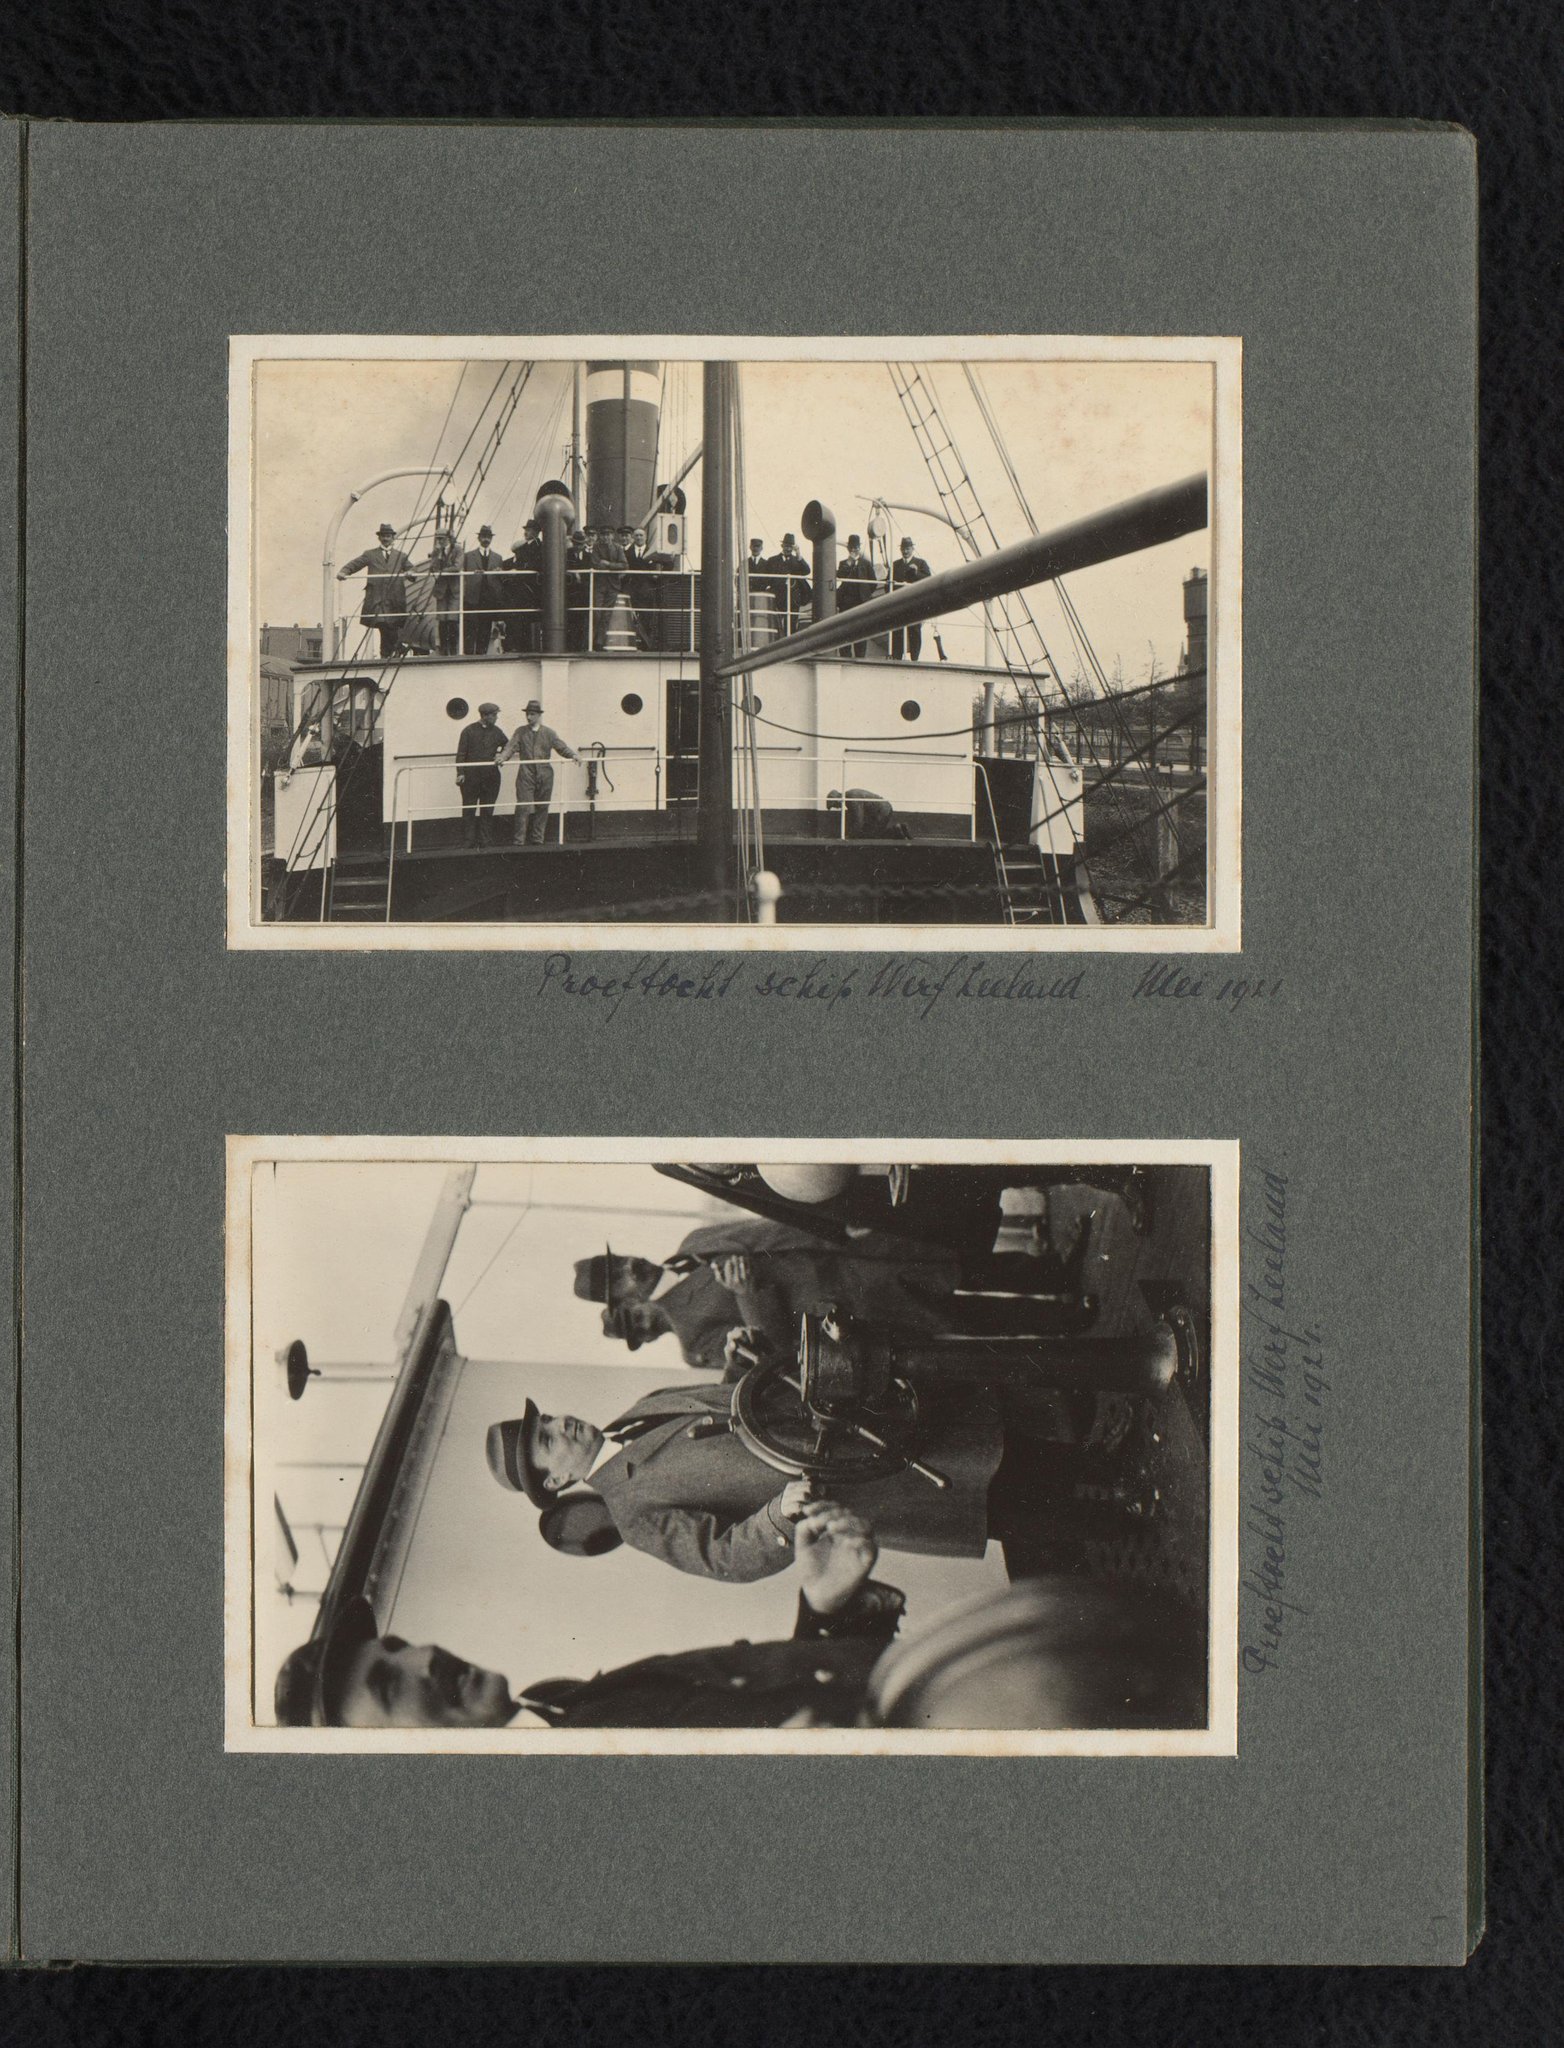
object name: photograph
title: Twee foto's van het schip Werf Zeeland tijdens een proefvaart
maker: hendrik herman van den berg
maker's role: amateurfotograaf, jurist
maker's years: 1875-1944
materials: paper, cardboard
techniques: gelatin silver print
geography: amsterdam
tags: parts of ship's exterior, historical persons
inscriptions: caption: ‘Proeftocht schip Werf Zeeland Mei 1921/ Proeftocht schip Werf Zeeland Mei 1921’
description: Deze foto's maken deel uit van een album.